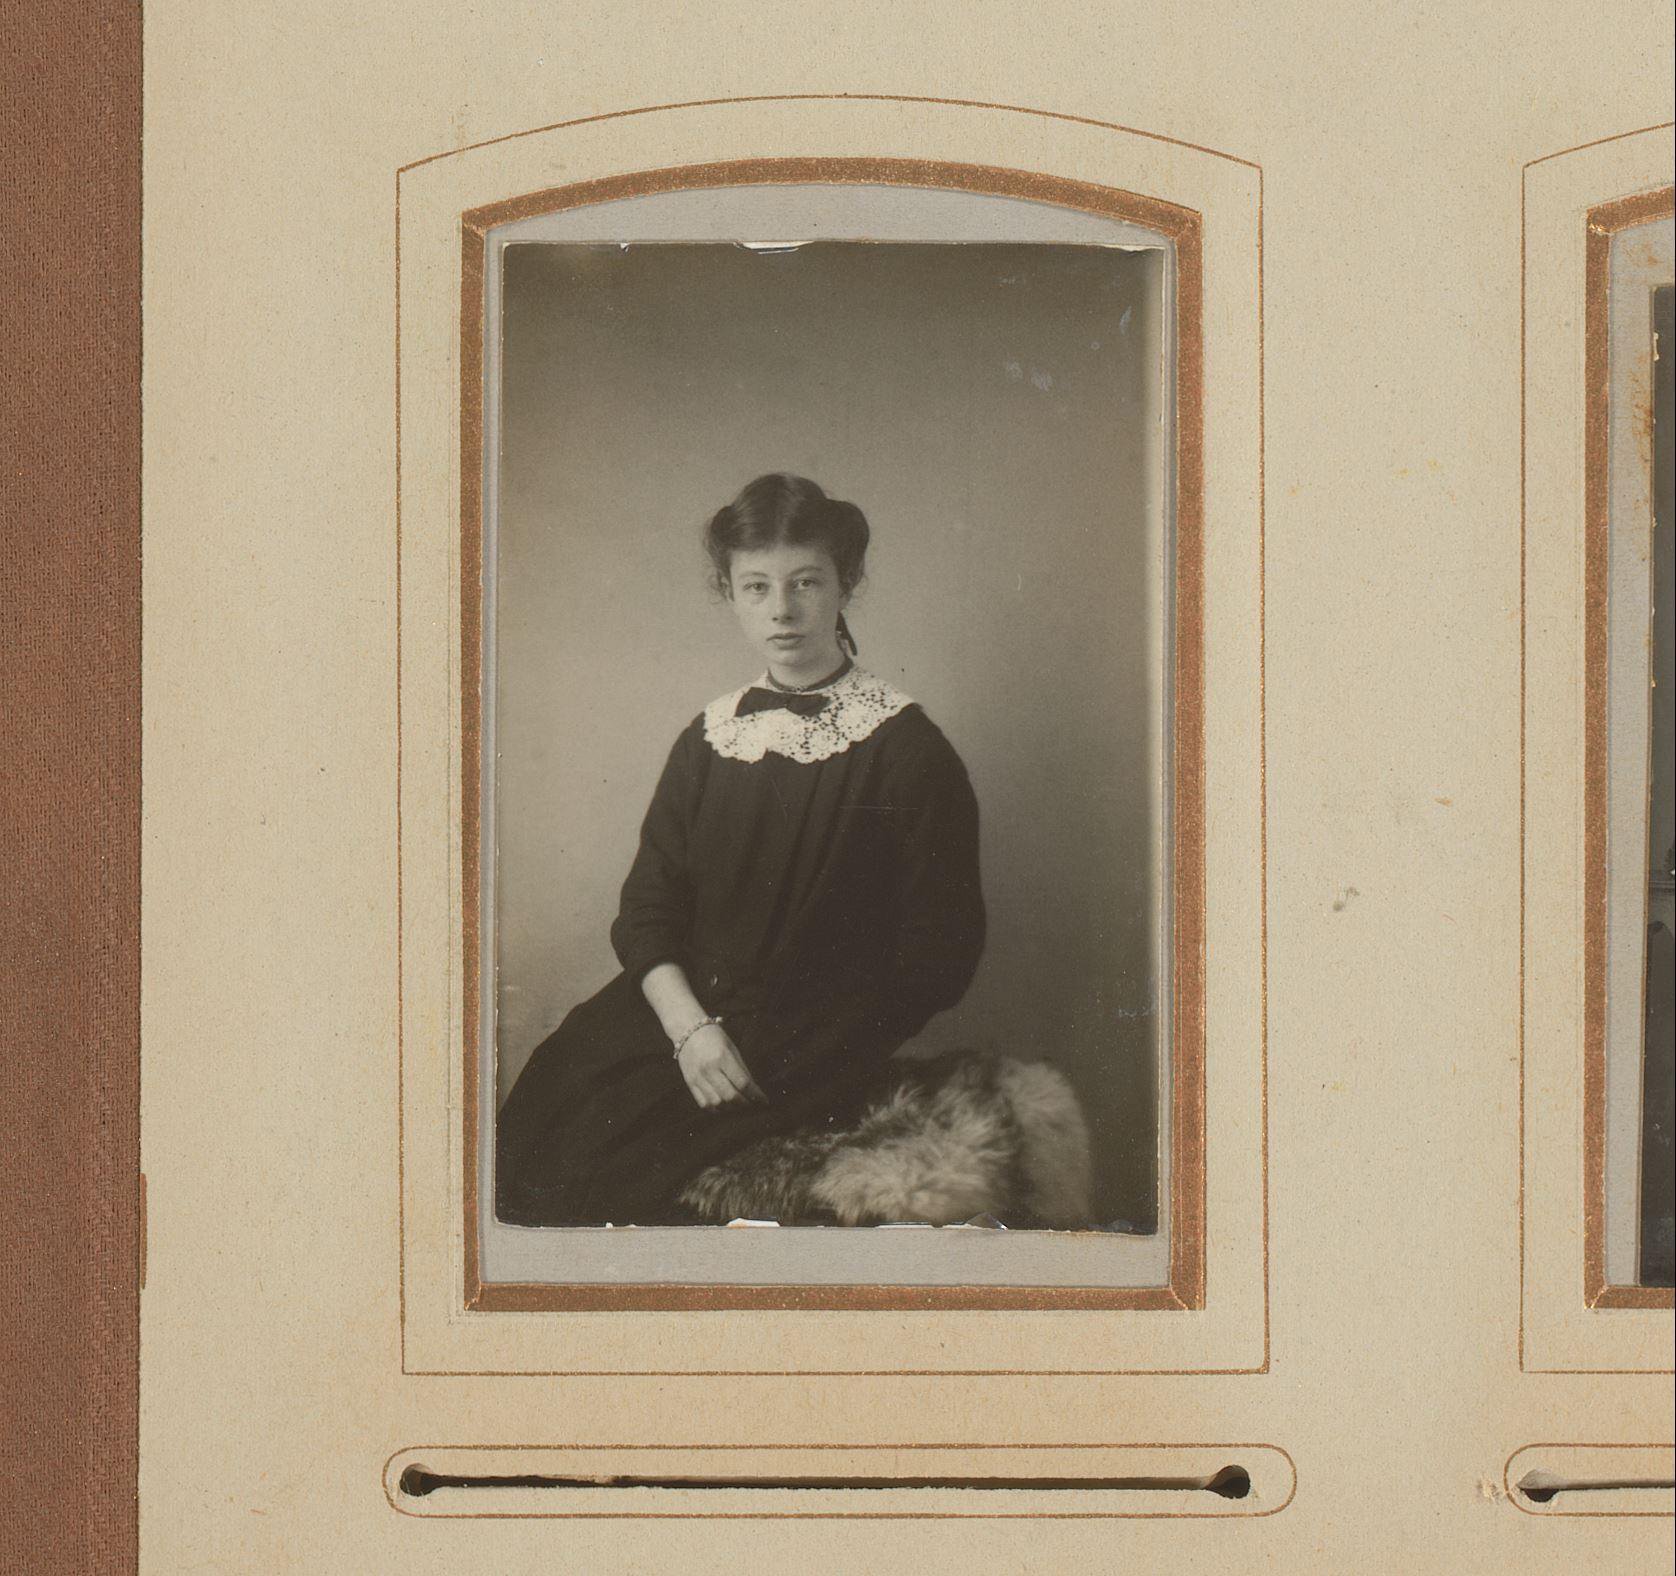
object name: photograph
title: Portret van een zittend meisje, aangeduid als Titia Mulder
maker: Anonymous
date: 1915-1925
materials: cardboard, photographic support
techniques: gelatin silver print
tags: sitting figure - aa - female human figure, historical persons - bb - woman, girl (child between toddler and youth)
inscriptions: annotation: ‘Titia Mulder/ geb. 8 Aug 1901’